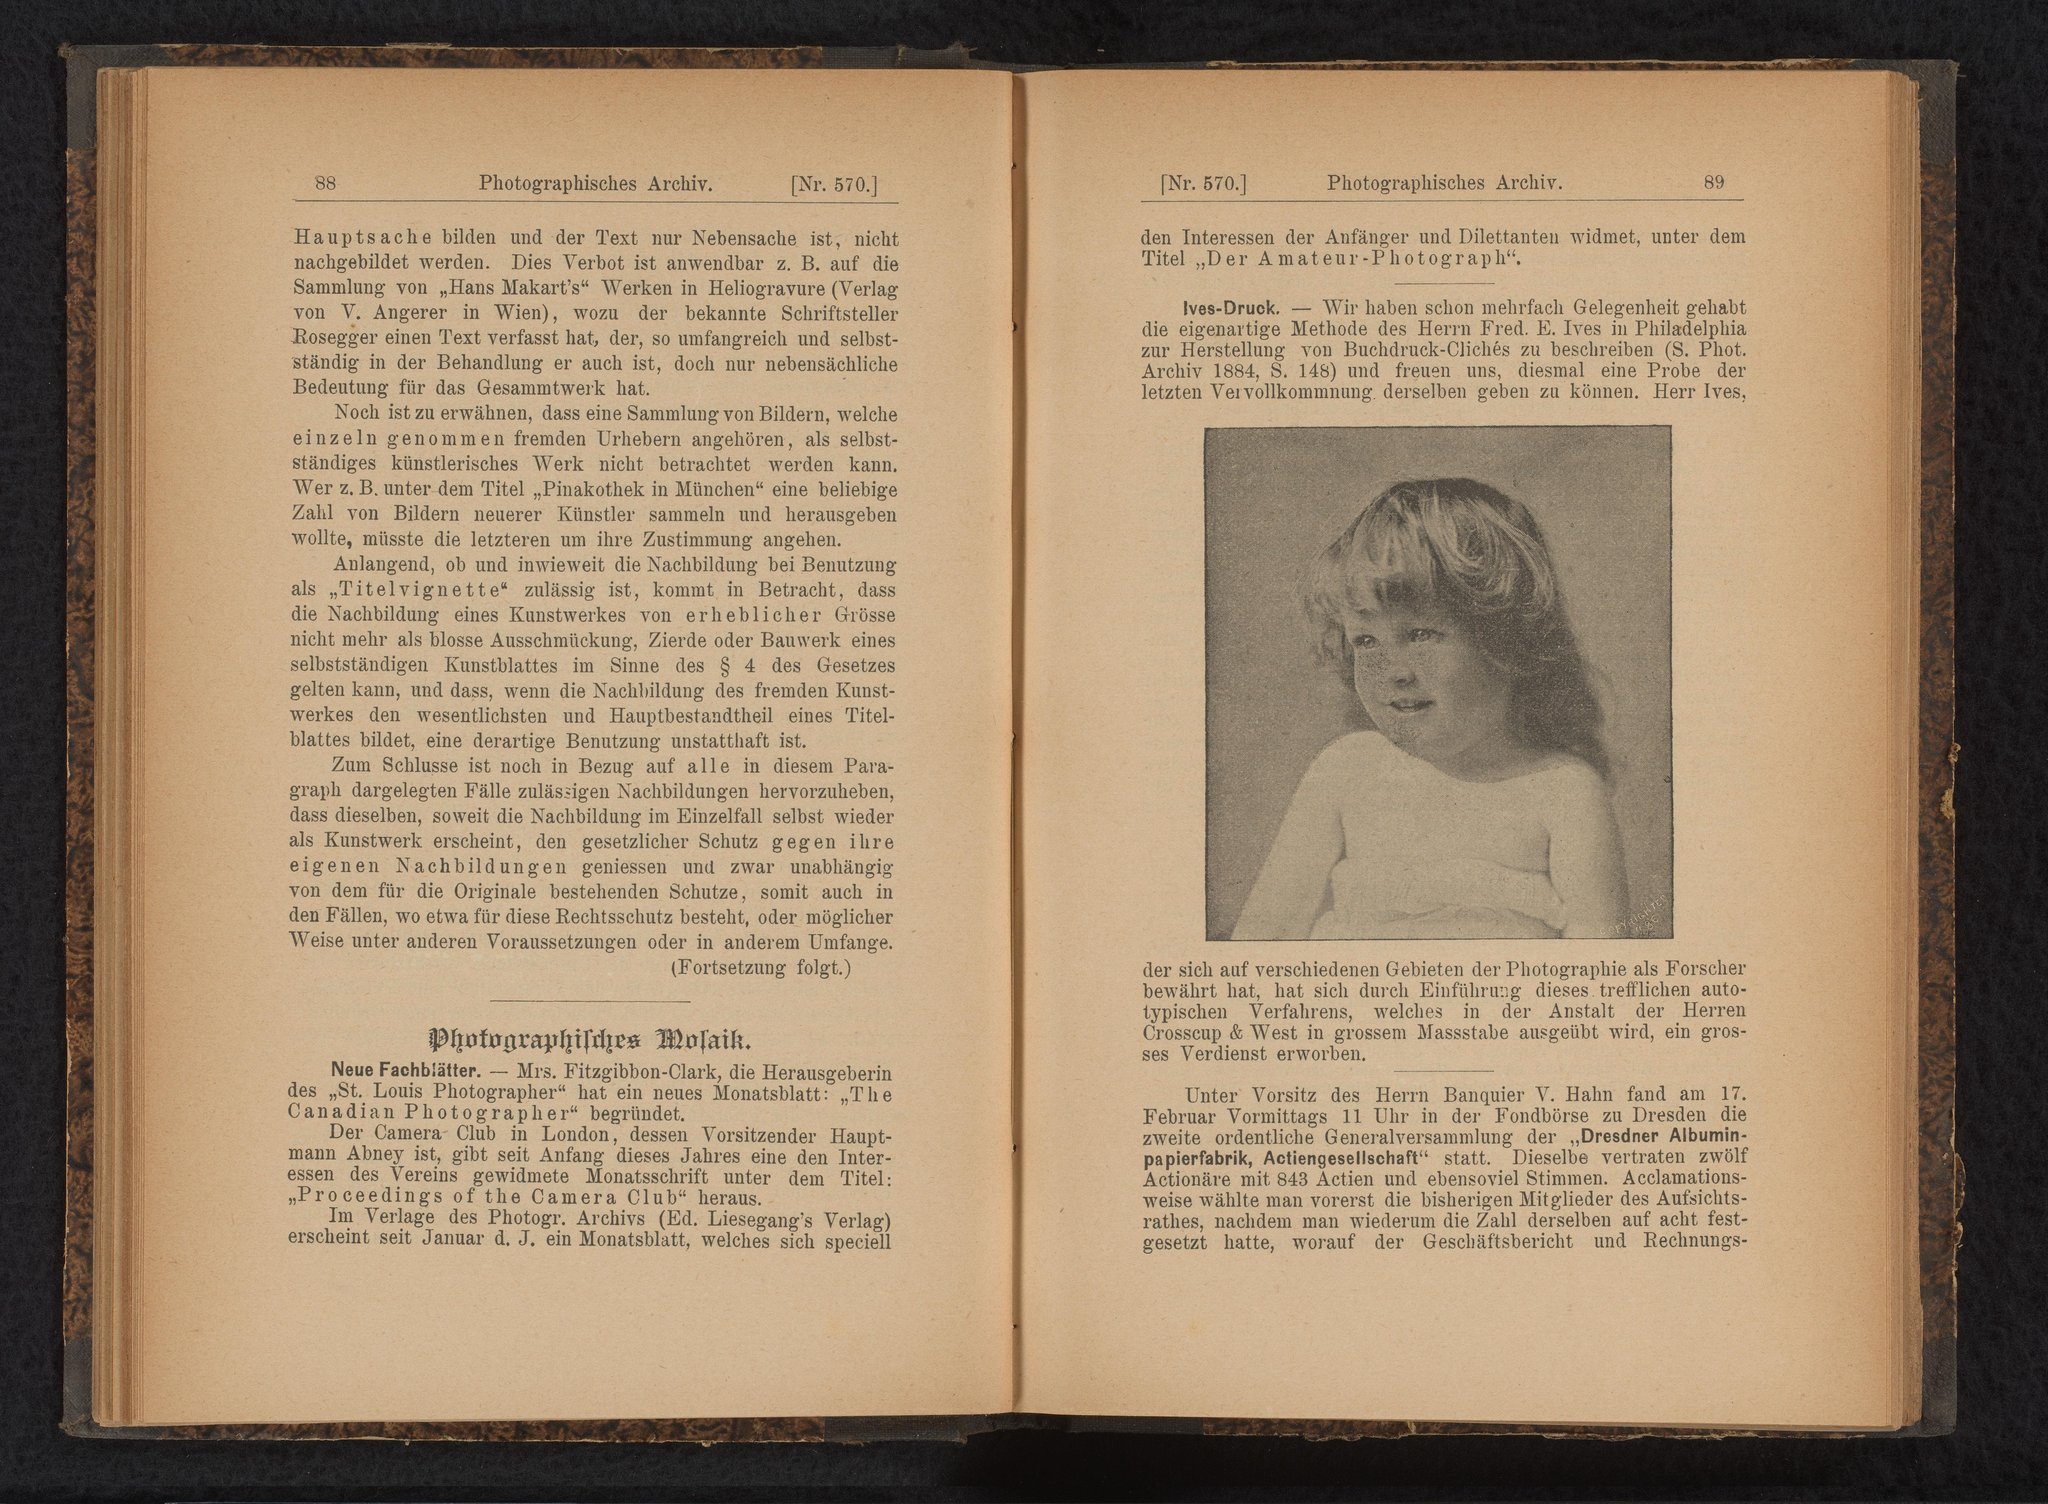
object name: page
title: Portret van een onbekend kind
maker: Anonymous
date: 1886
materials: paper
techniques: autotype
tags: child, historical persons not known by name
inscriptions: copyright notice: ‘Copyrighted/ "86’